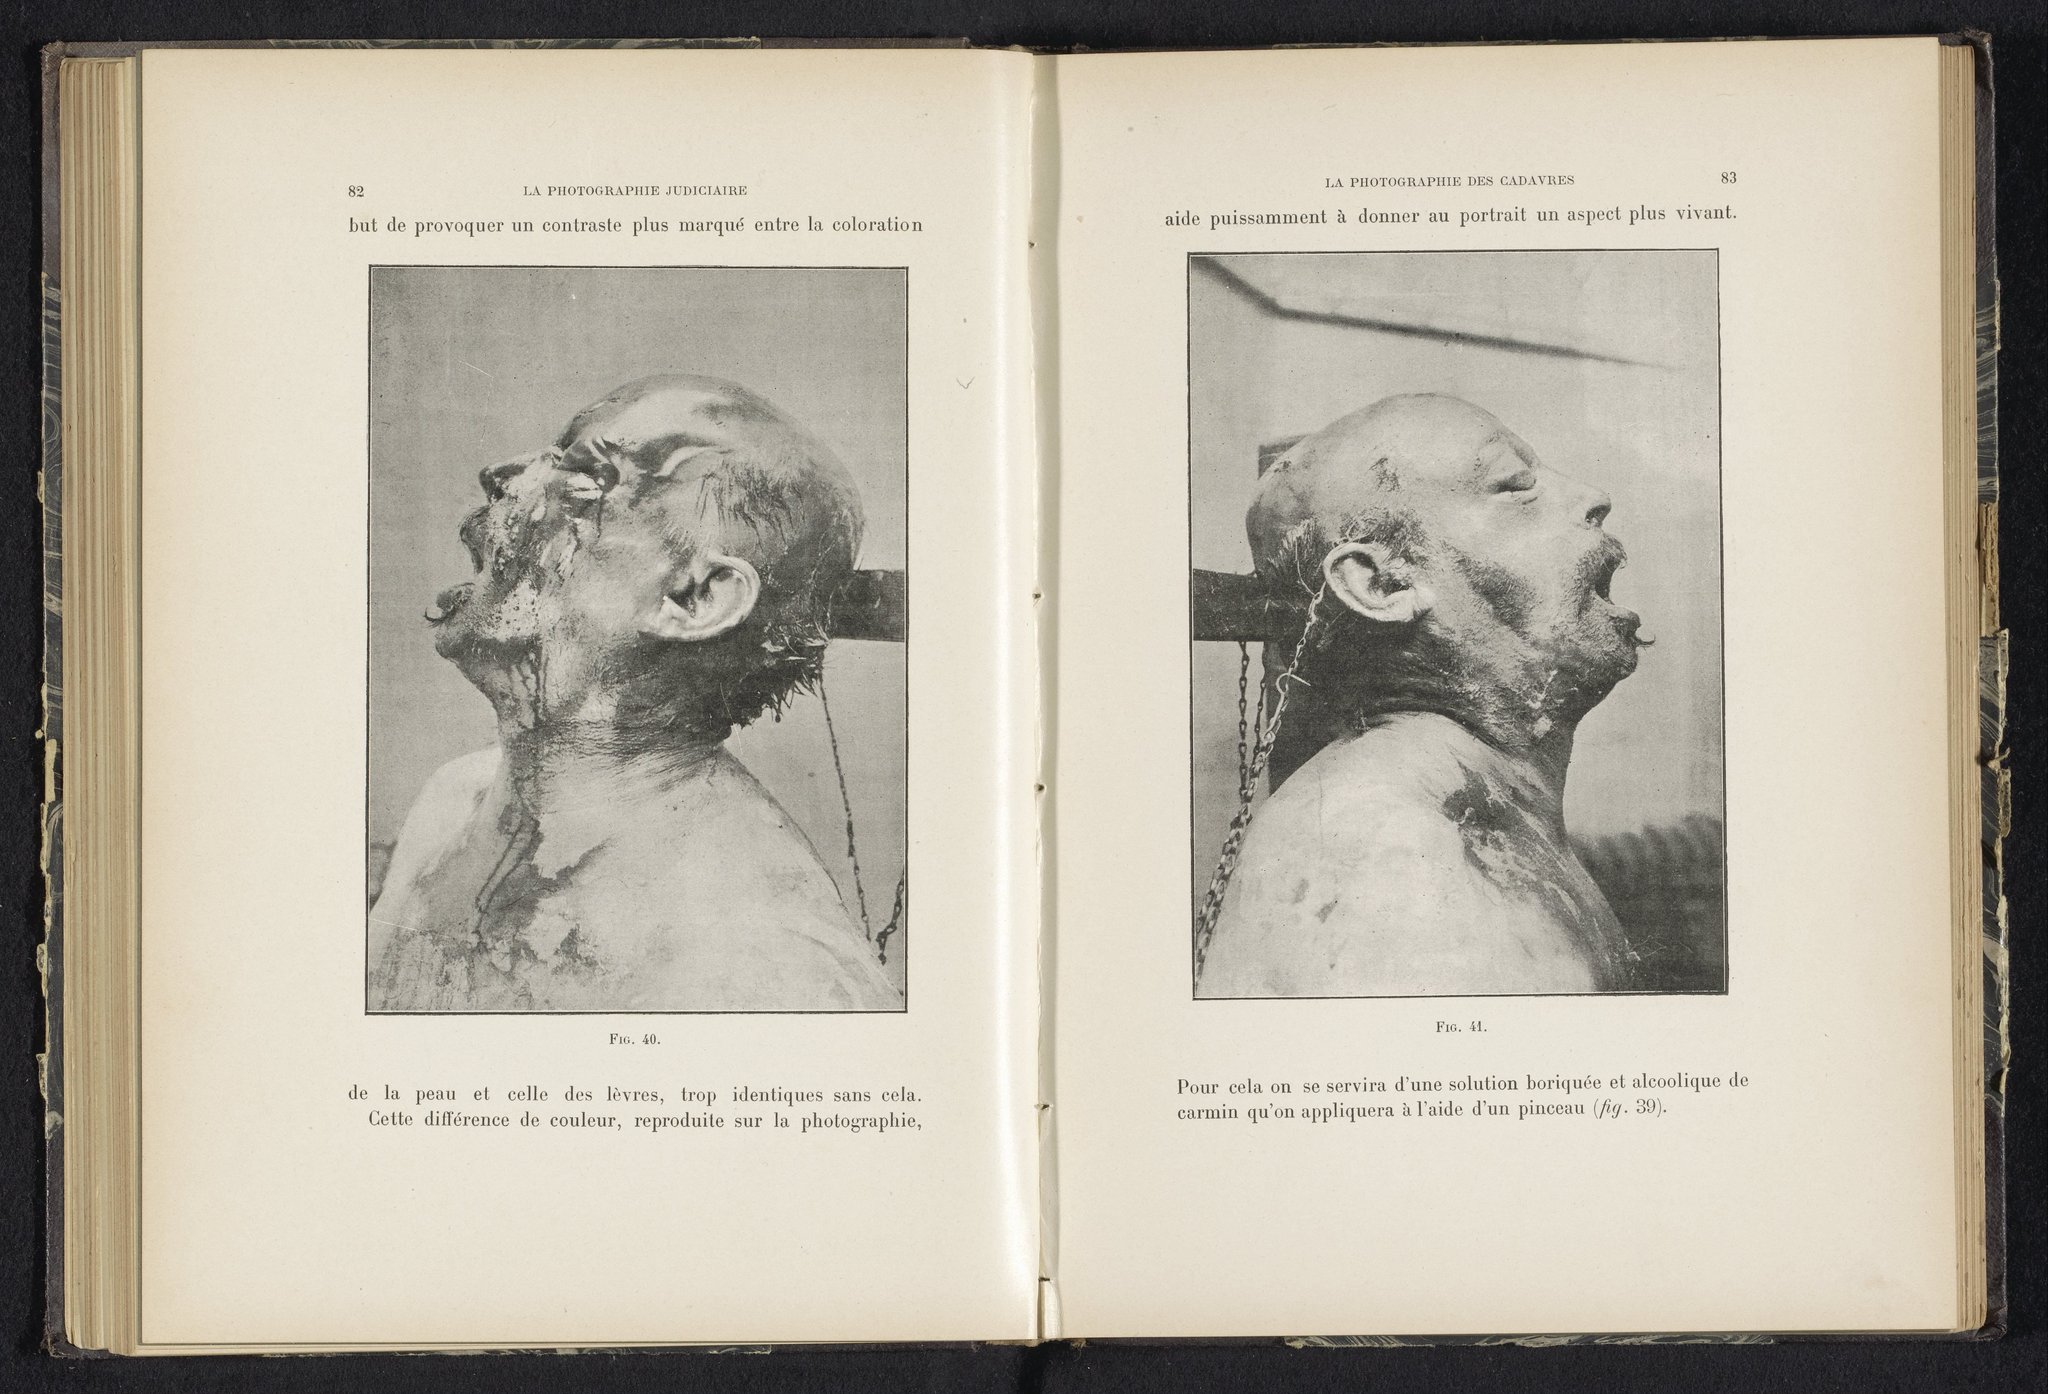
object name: photomechanical print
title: Hoofd van een dode man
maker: Anonymous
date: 1893-1903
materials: paper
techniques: autotype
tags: the corpse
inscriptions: number: ‘Fig. 41.’